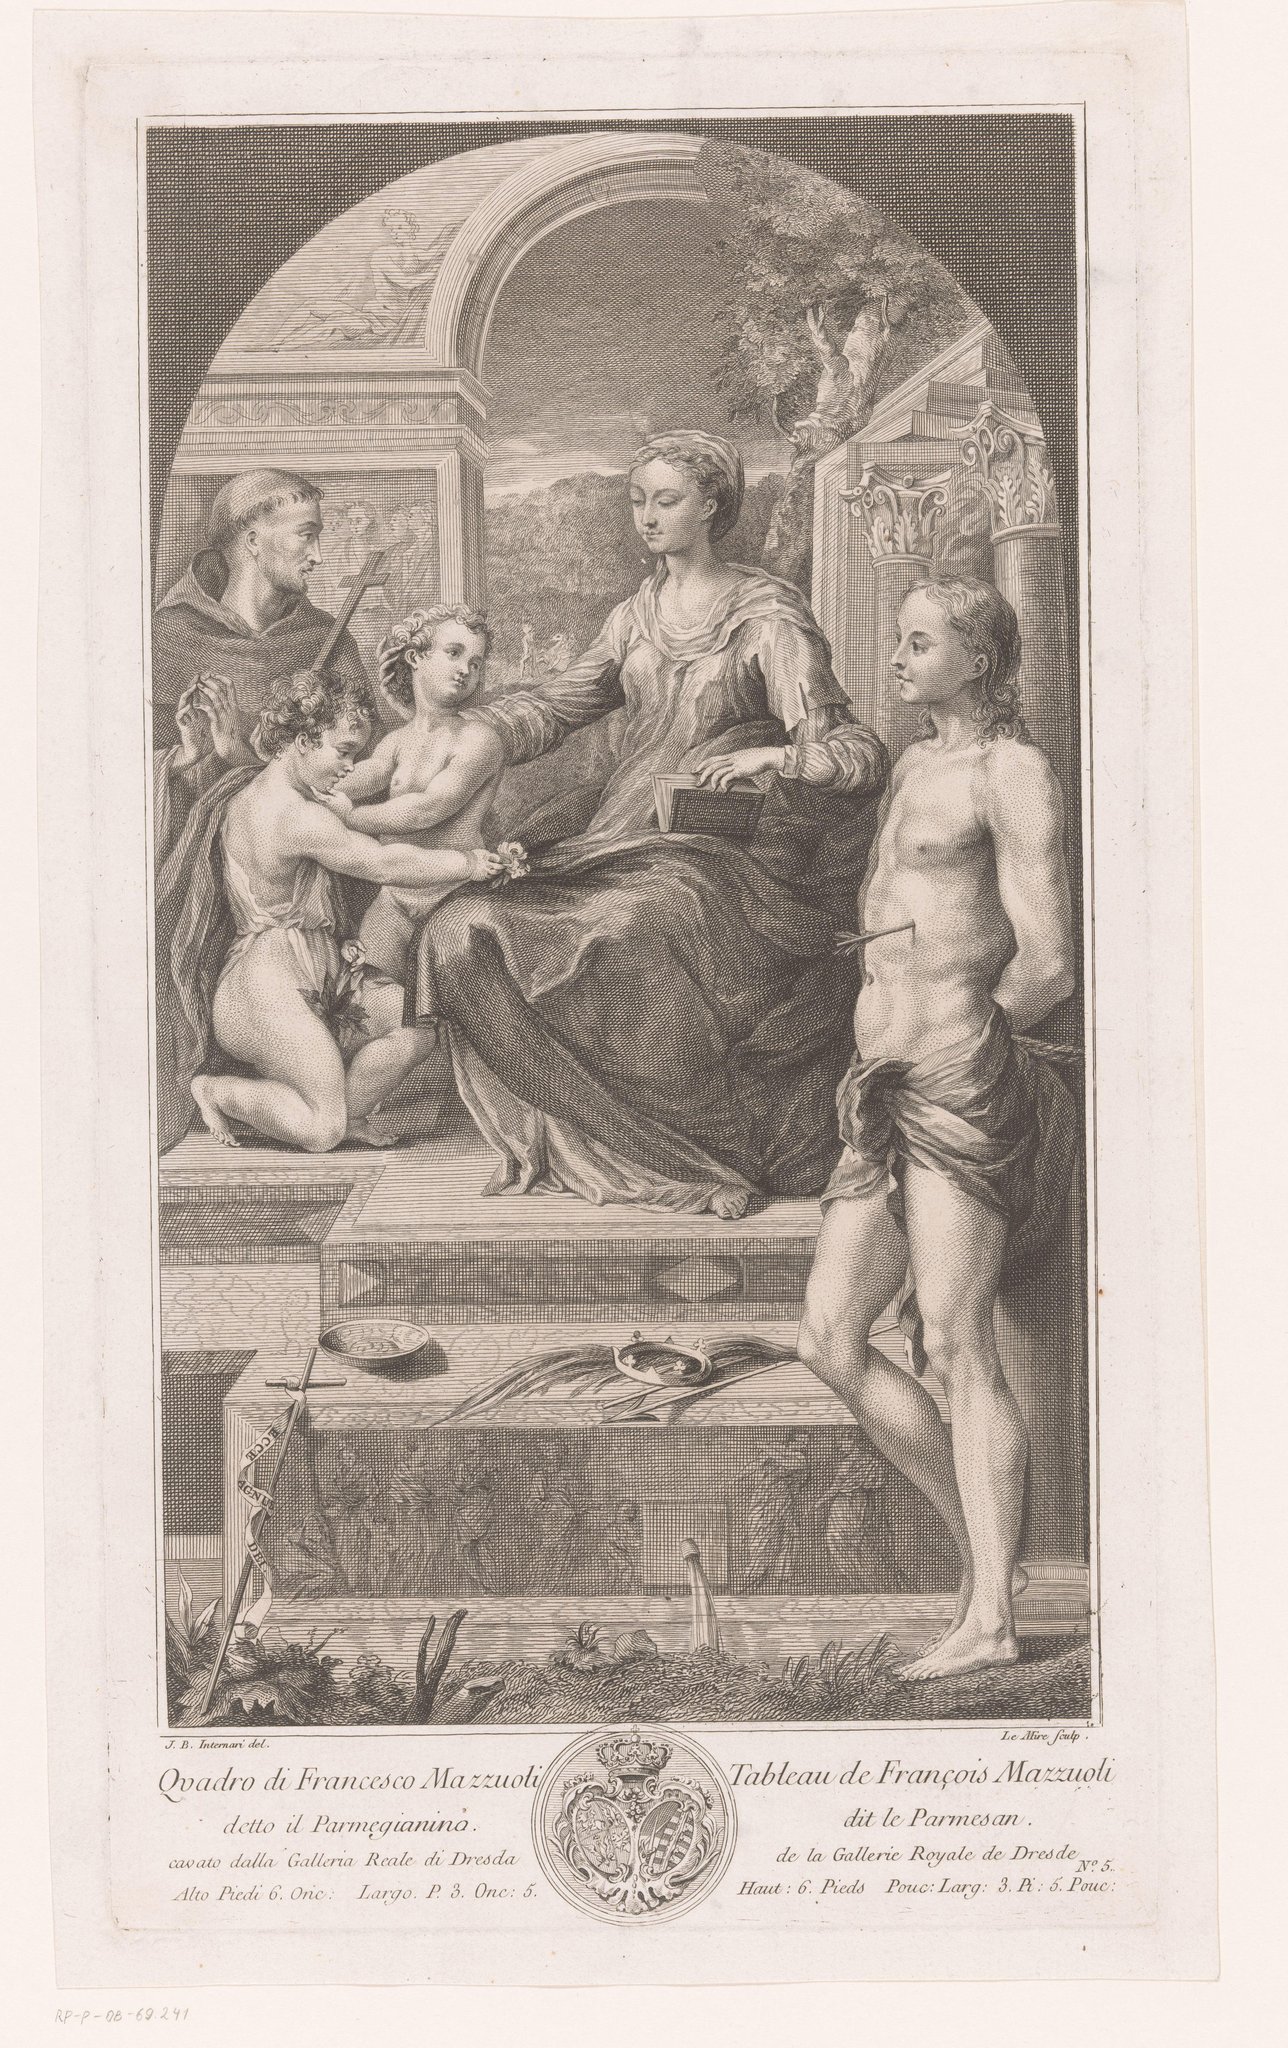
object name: print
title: Recueil d'estampes d'apres les plus célèbres tableaux de la Galerie Royale de Dresde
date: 1753-1757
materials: paper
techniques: engraving, etching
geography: france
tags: st. sebastian, tied to a tree or a pillar, is pierced by arrows, founder of the order of friars minor (franciscans), francis(cus) of assisi; possible attributes: book, crucifix, lily, skull, stigmata, mary, the christ-child and john the baptist (as child) with others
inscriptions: collector's mark: Lugt 2228